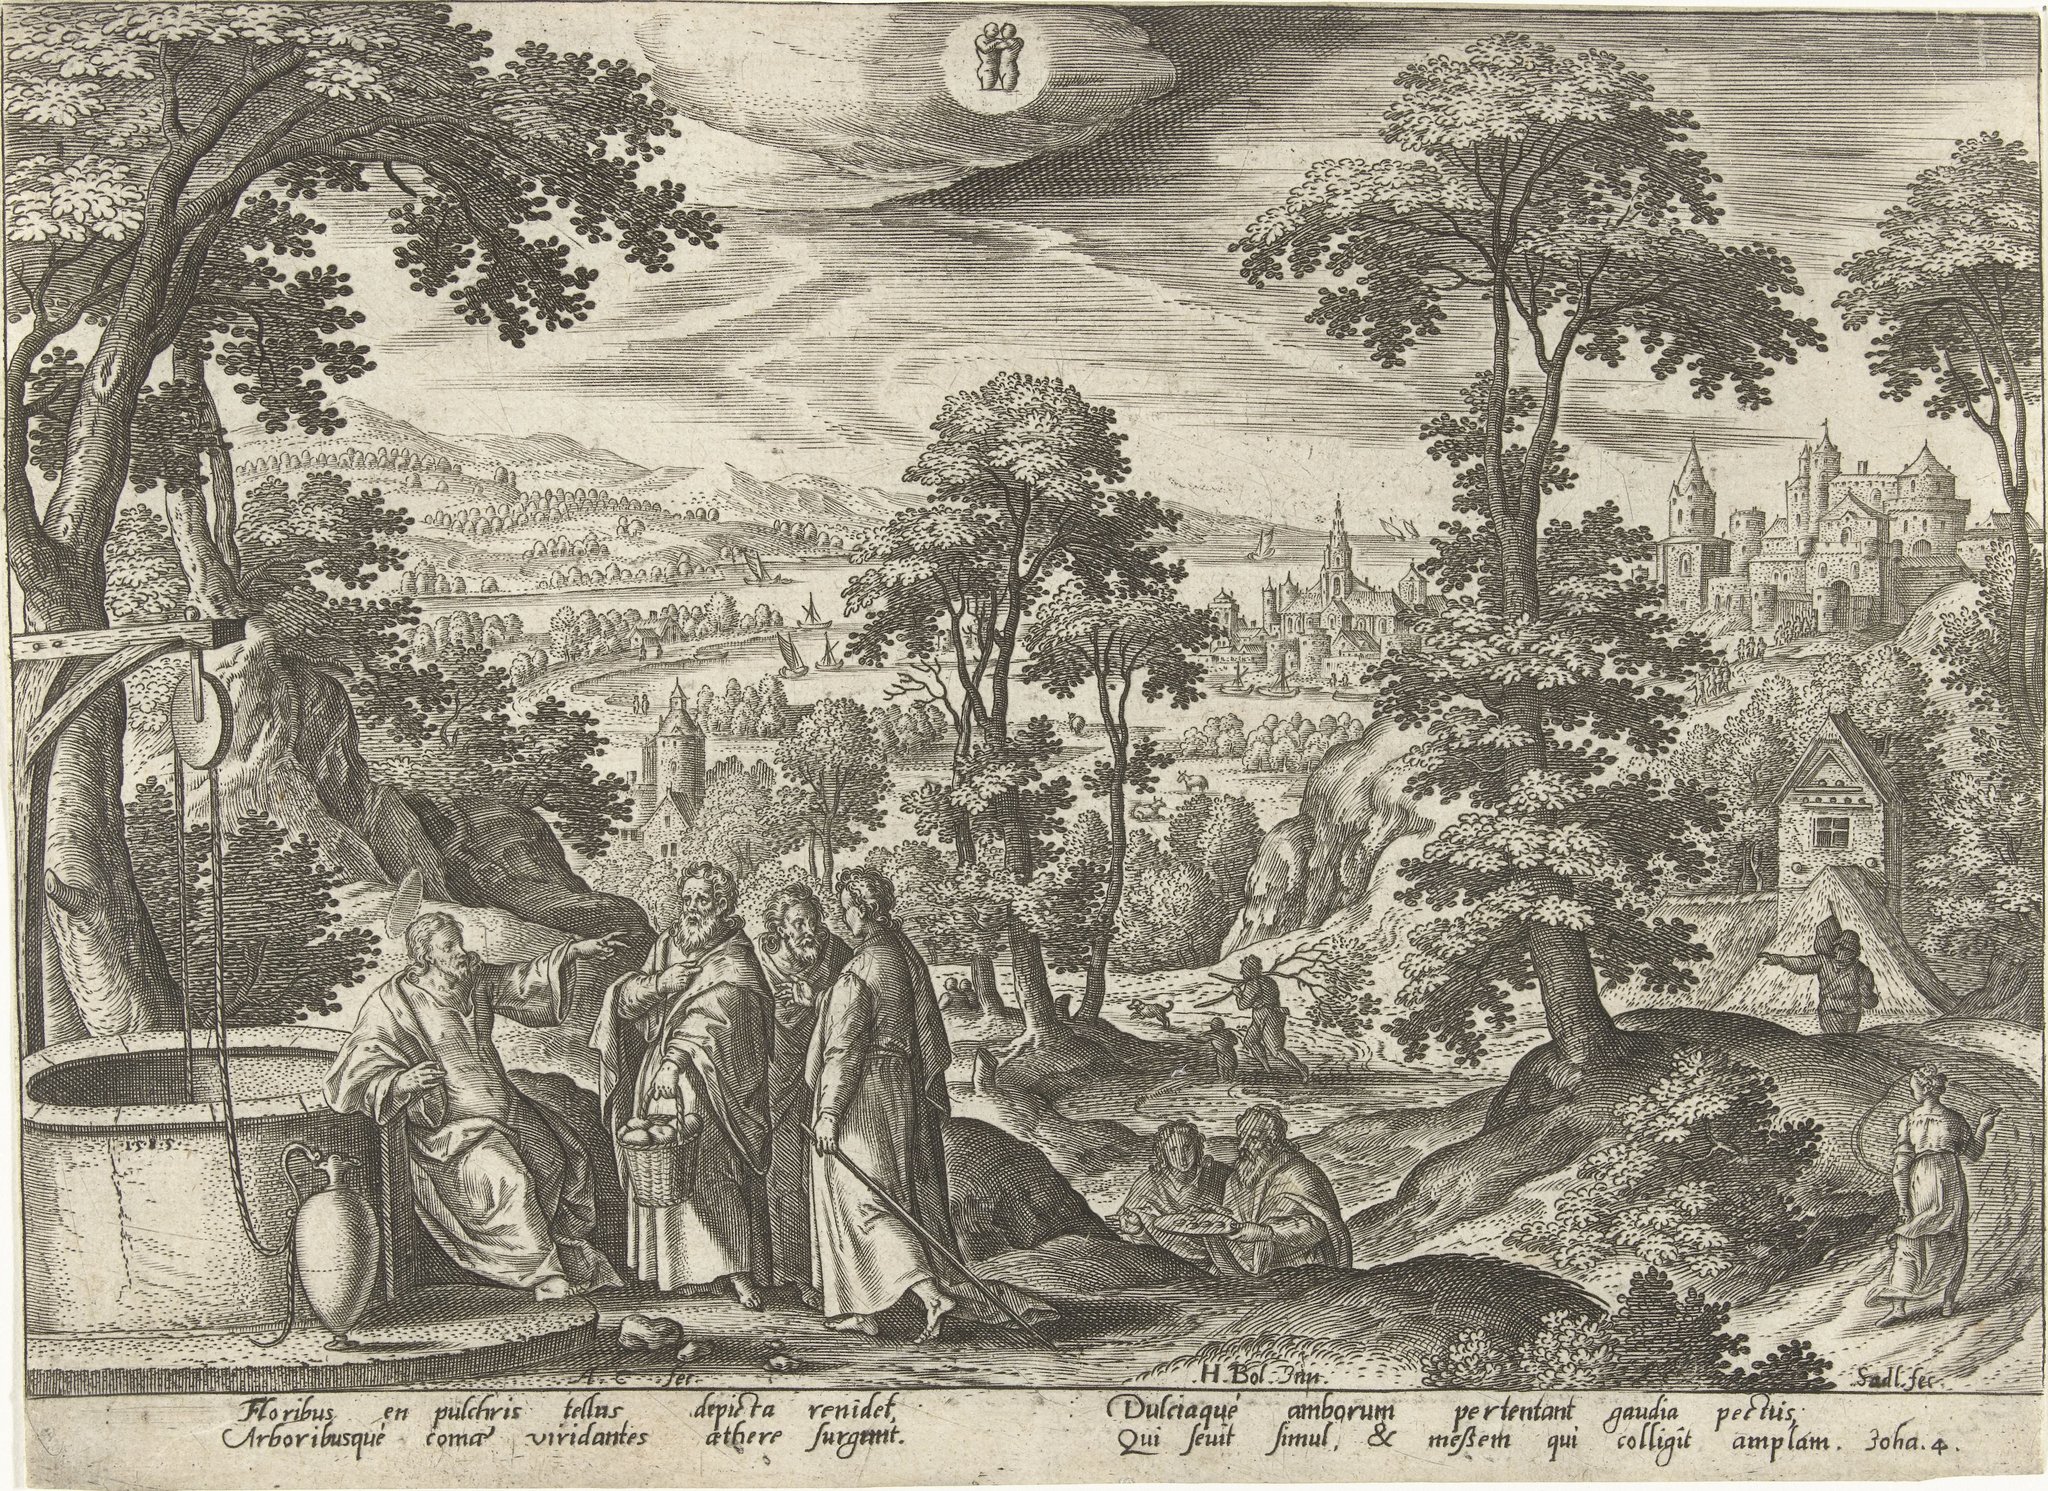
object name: print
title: Mei: Christus en de Samaritaanse vrouw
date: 1585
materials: paper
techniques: engraving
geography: antwerp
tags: the woman of samaria (john 4:4-42), landscape symbolizing may (+ with gemini (may))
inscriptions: collector's mark: Lugt 2760, collector's mark: Lugt 2228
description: Een lentelandschap. In de lucht het astrologisch teken van mei: de Tweeling. Christus rust uit bij de bron van Jakob. Zijn leerlingen bevragen hem over de Samaritaanse vrouw, die juist vertrokken is (Joh.4). De prent heeft een Latijns onderschrift en is deel van een serie over het leven van Christus uitgebeeld in de twaalf maanden van het jaar.